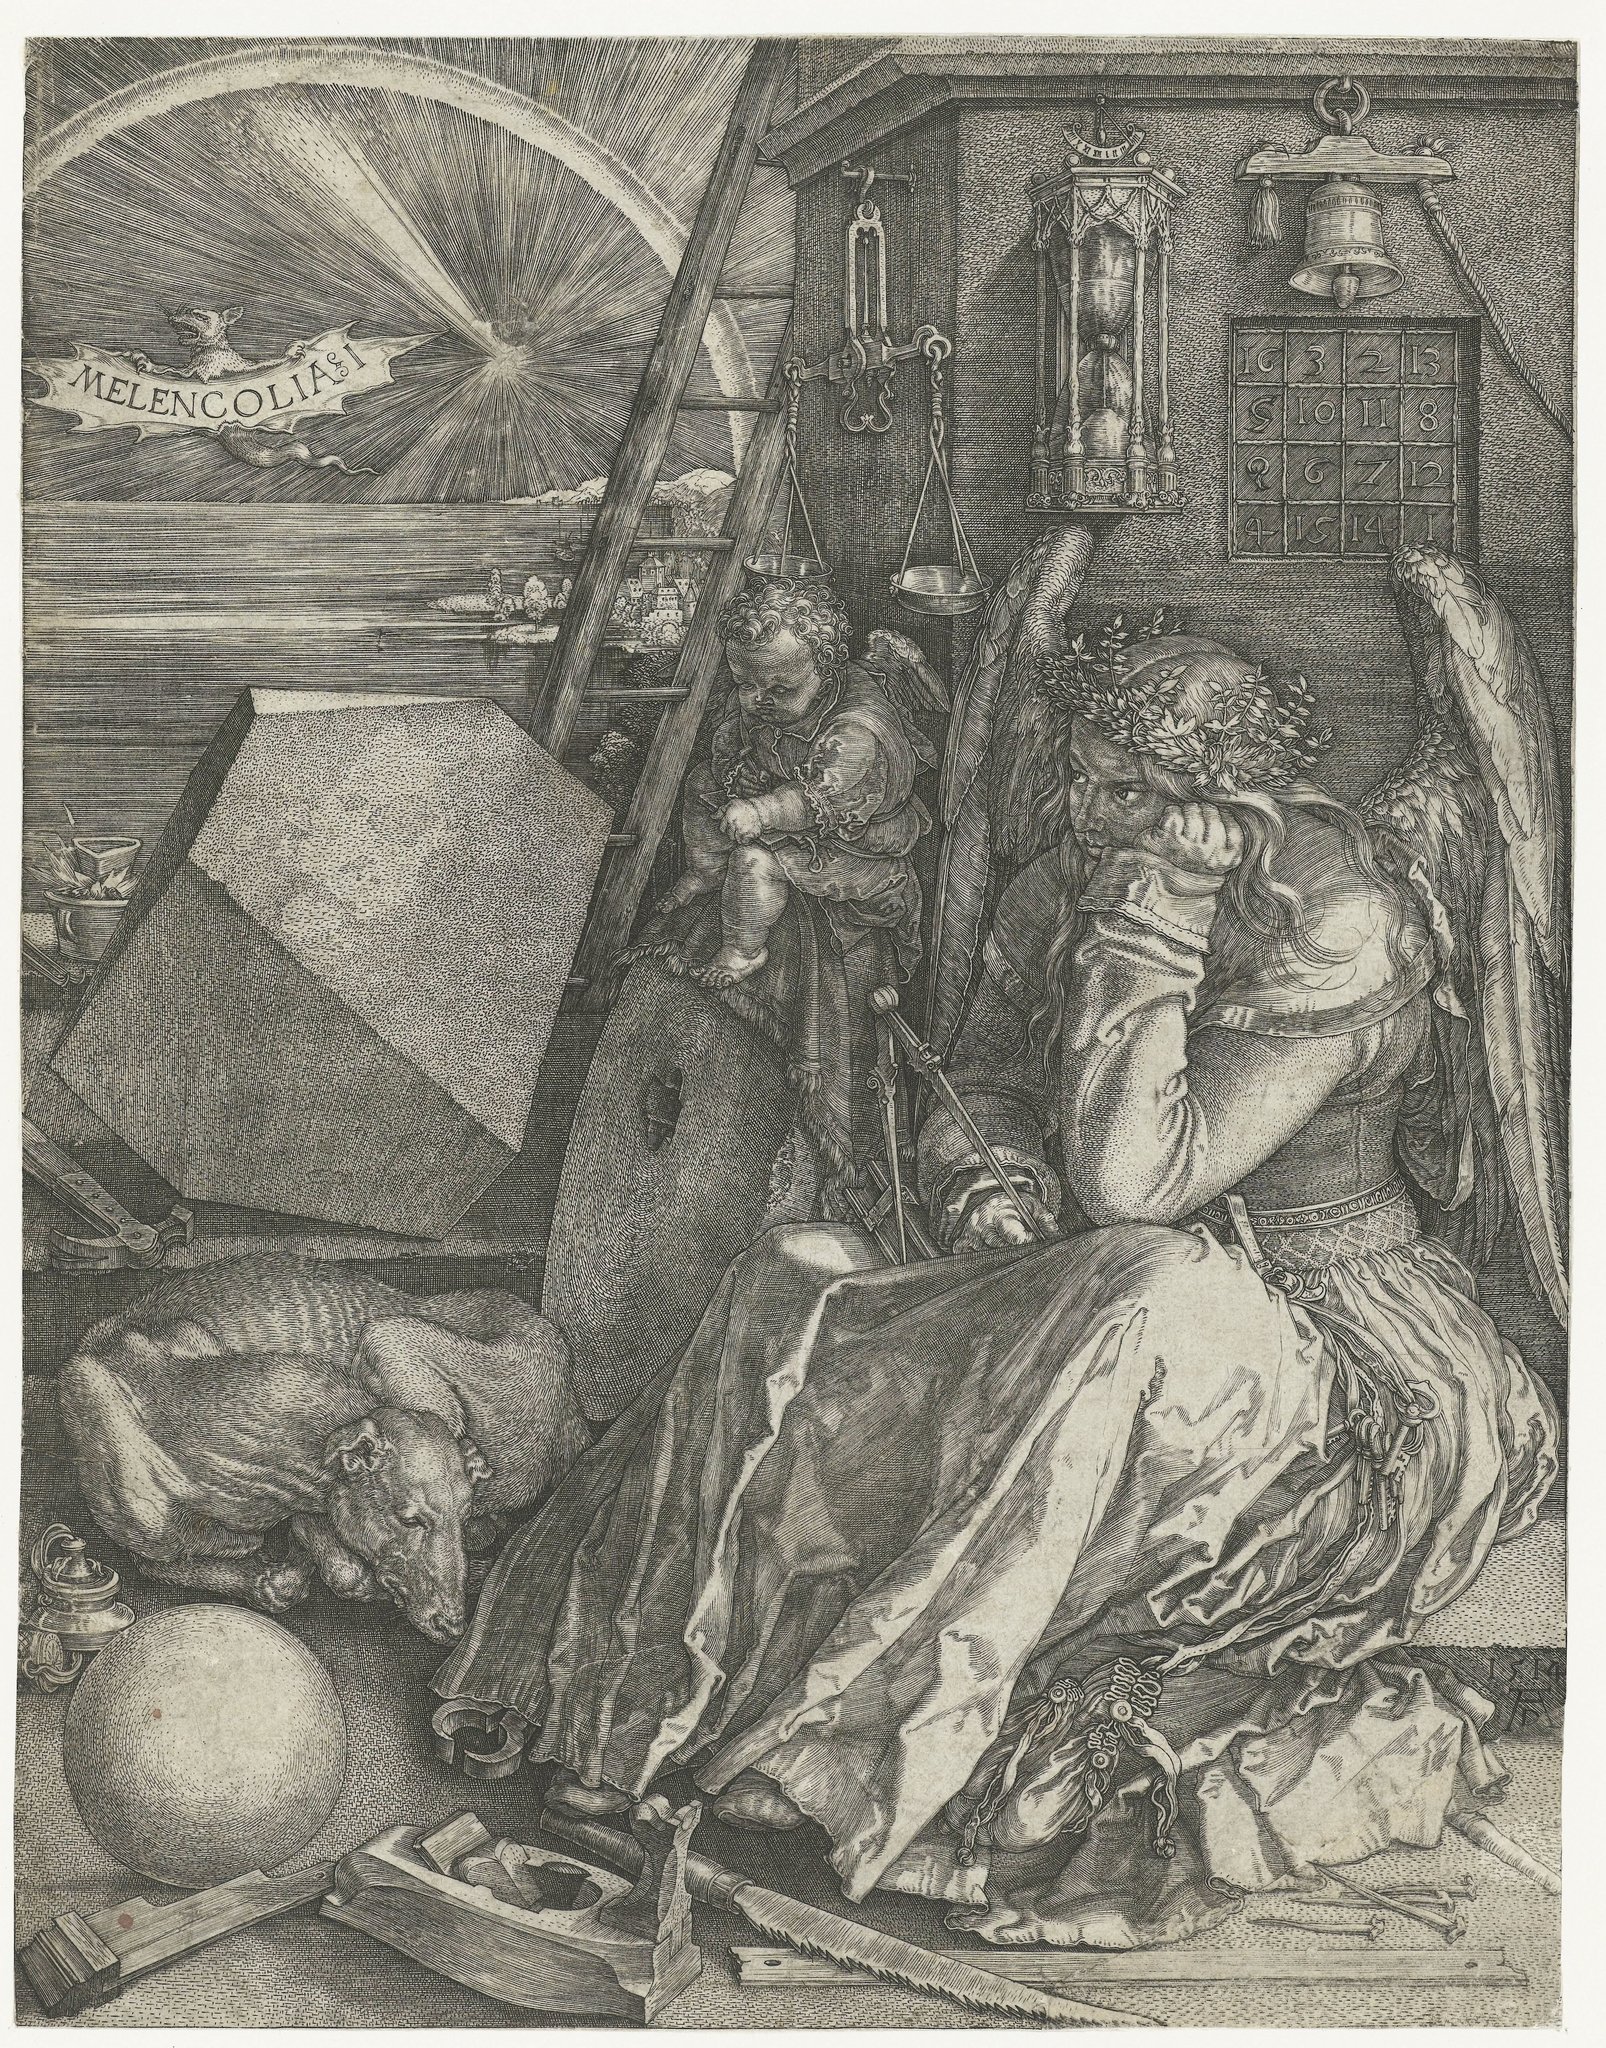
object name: print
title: Melancholie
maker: albrecht dürer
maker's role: draughtsman, painter, print maker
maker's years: 1471-1528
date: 1514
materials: paper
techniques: engraving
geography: nuremberg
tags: melancholic temperament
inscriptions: collector's mark: Lugt 2228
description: Het melancholische temperament, in de gedaante van een gevleugelde vrouw die peinzend voor zich uitkijkt, de kaak op de linkerhand gesteund, een passer in de hand. Om haar heen diverse (meet)instrumenten, zoals een weegschaal, een zandloper en een zaag. Aan haar voeten een hond. Naast haar een putto die iets op een tablet schrijft.